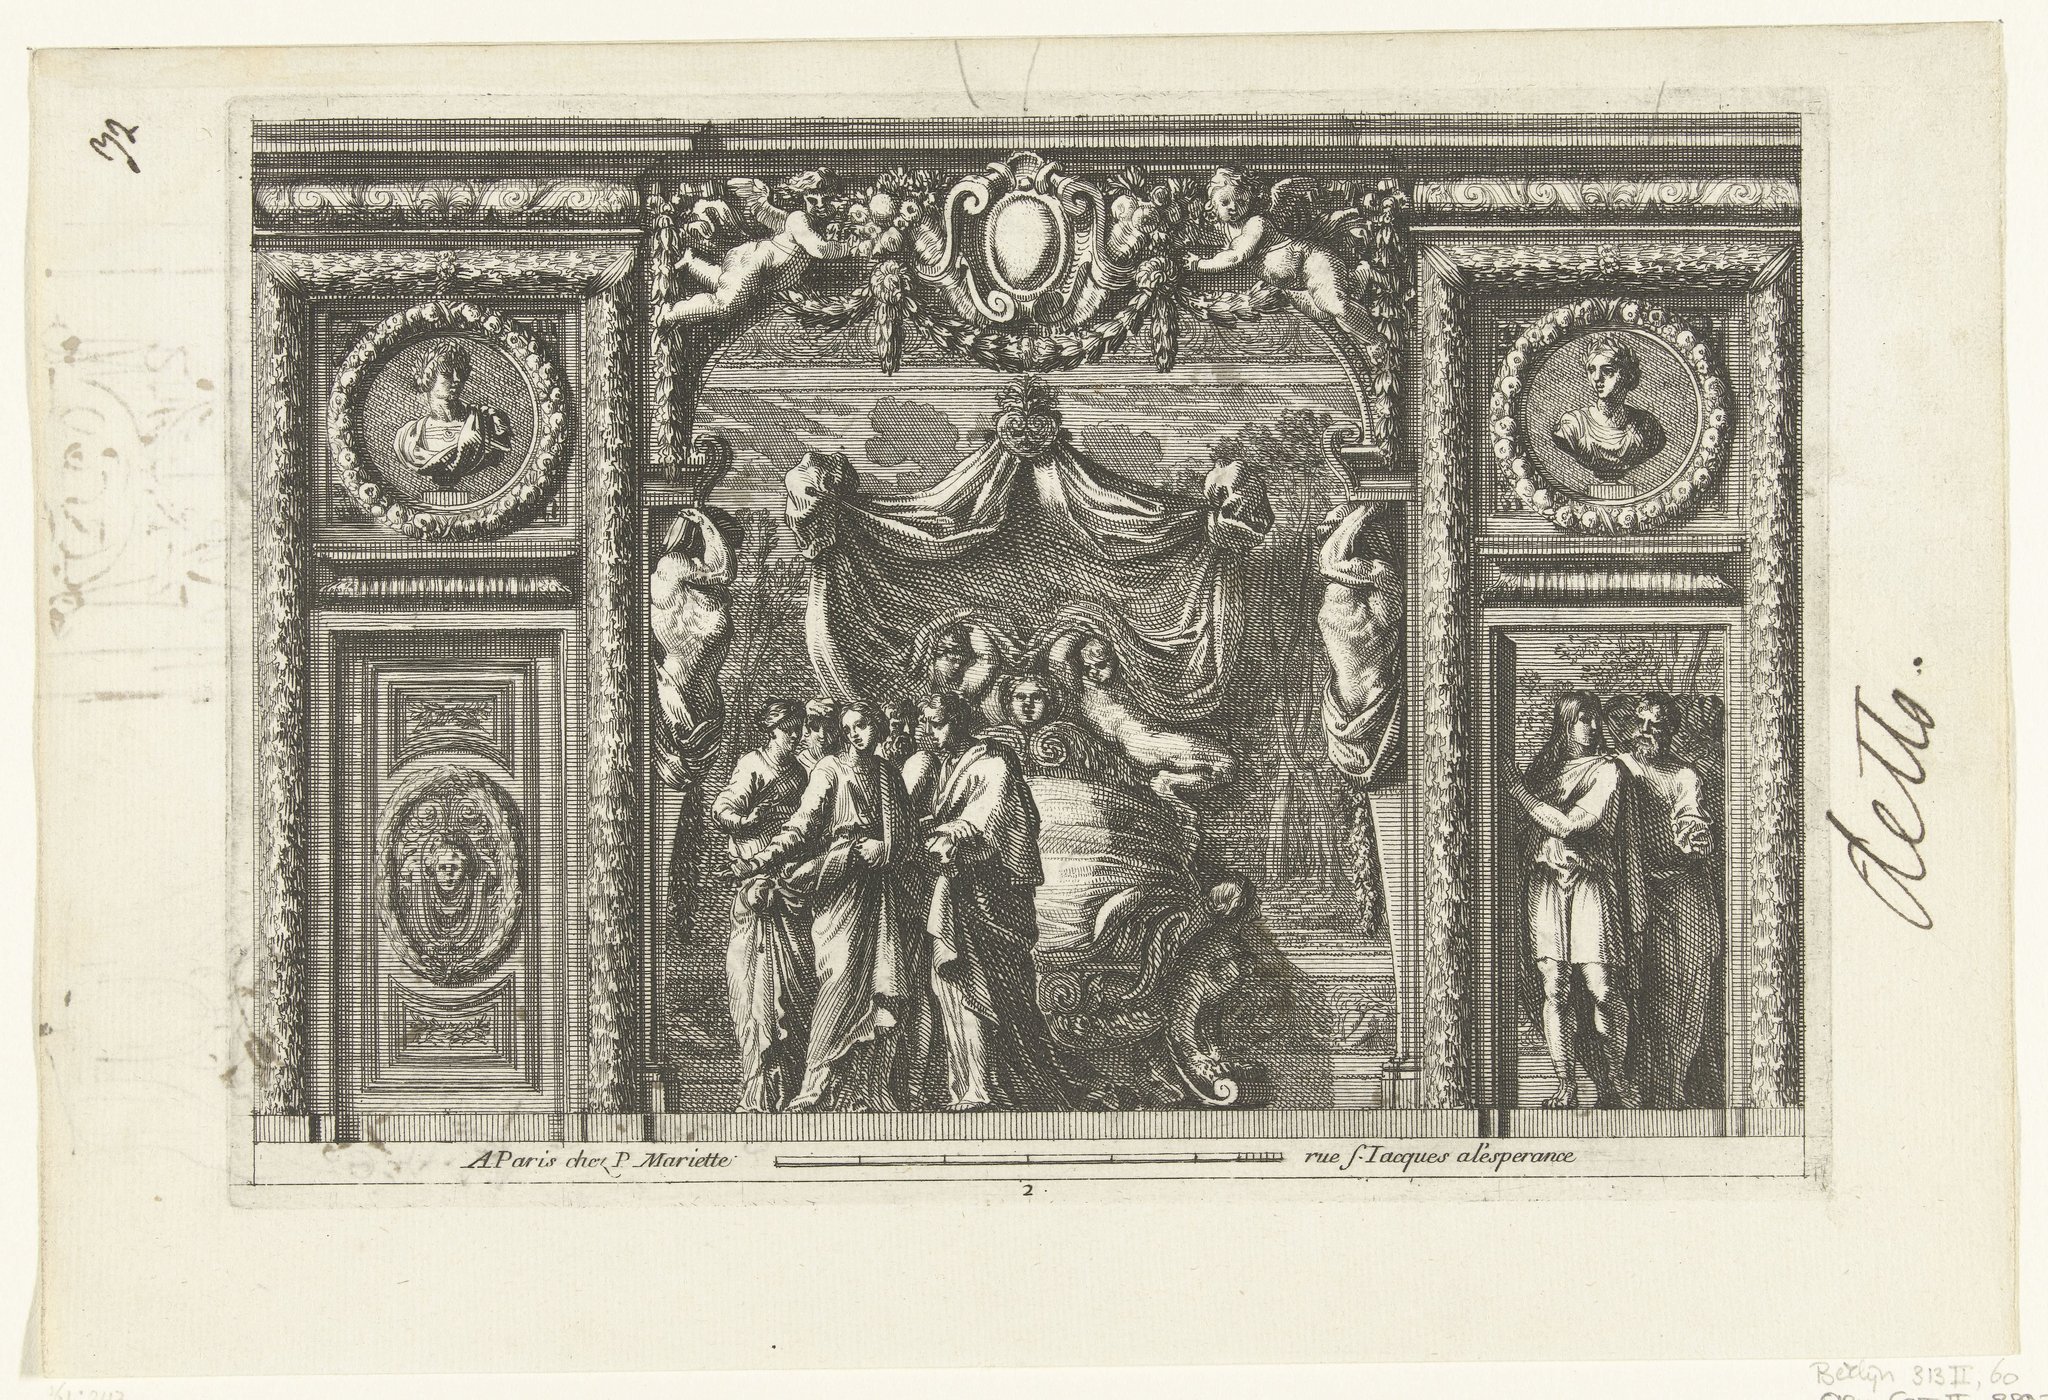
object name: ornament print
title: Alcoves a la Romaine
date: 1656-1657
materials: paper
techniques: etching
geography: france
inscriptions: inscription: ‘32 / detto’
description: Alkoof met een groep staand voor een bed geflankeerd door twee termen en twee deuren met daarboven medaillons met keizersportretten. Mogelijk het verhaal van Titus en Berenice. Rechtsonder 6 genummerd.